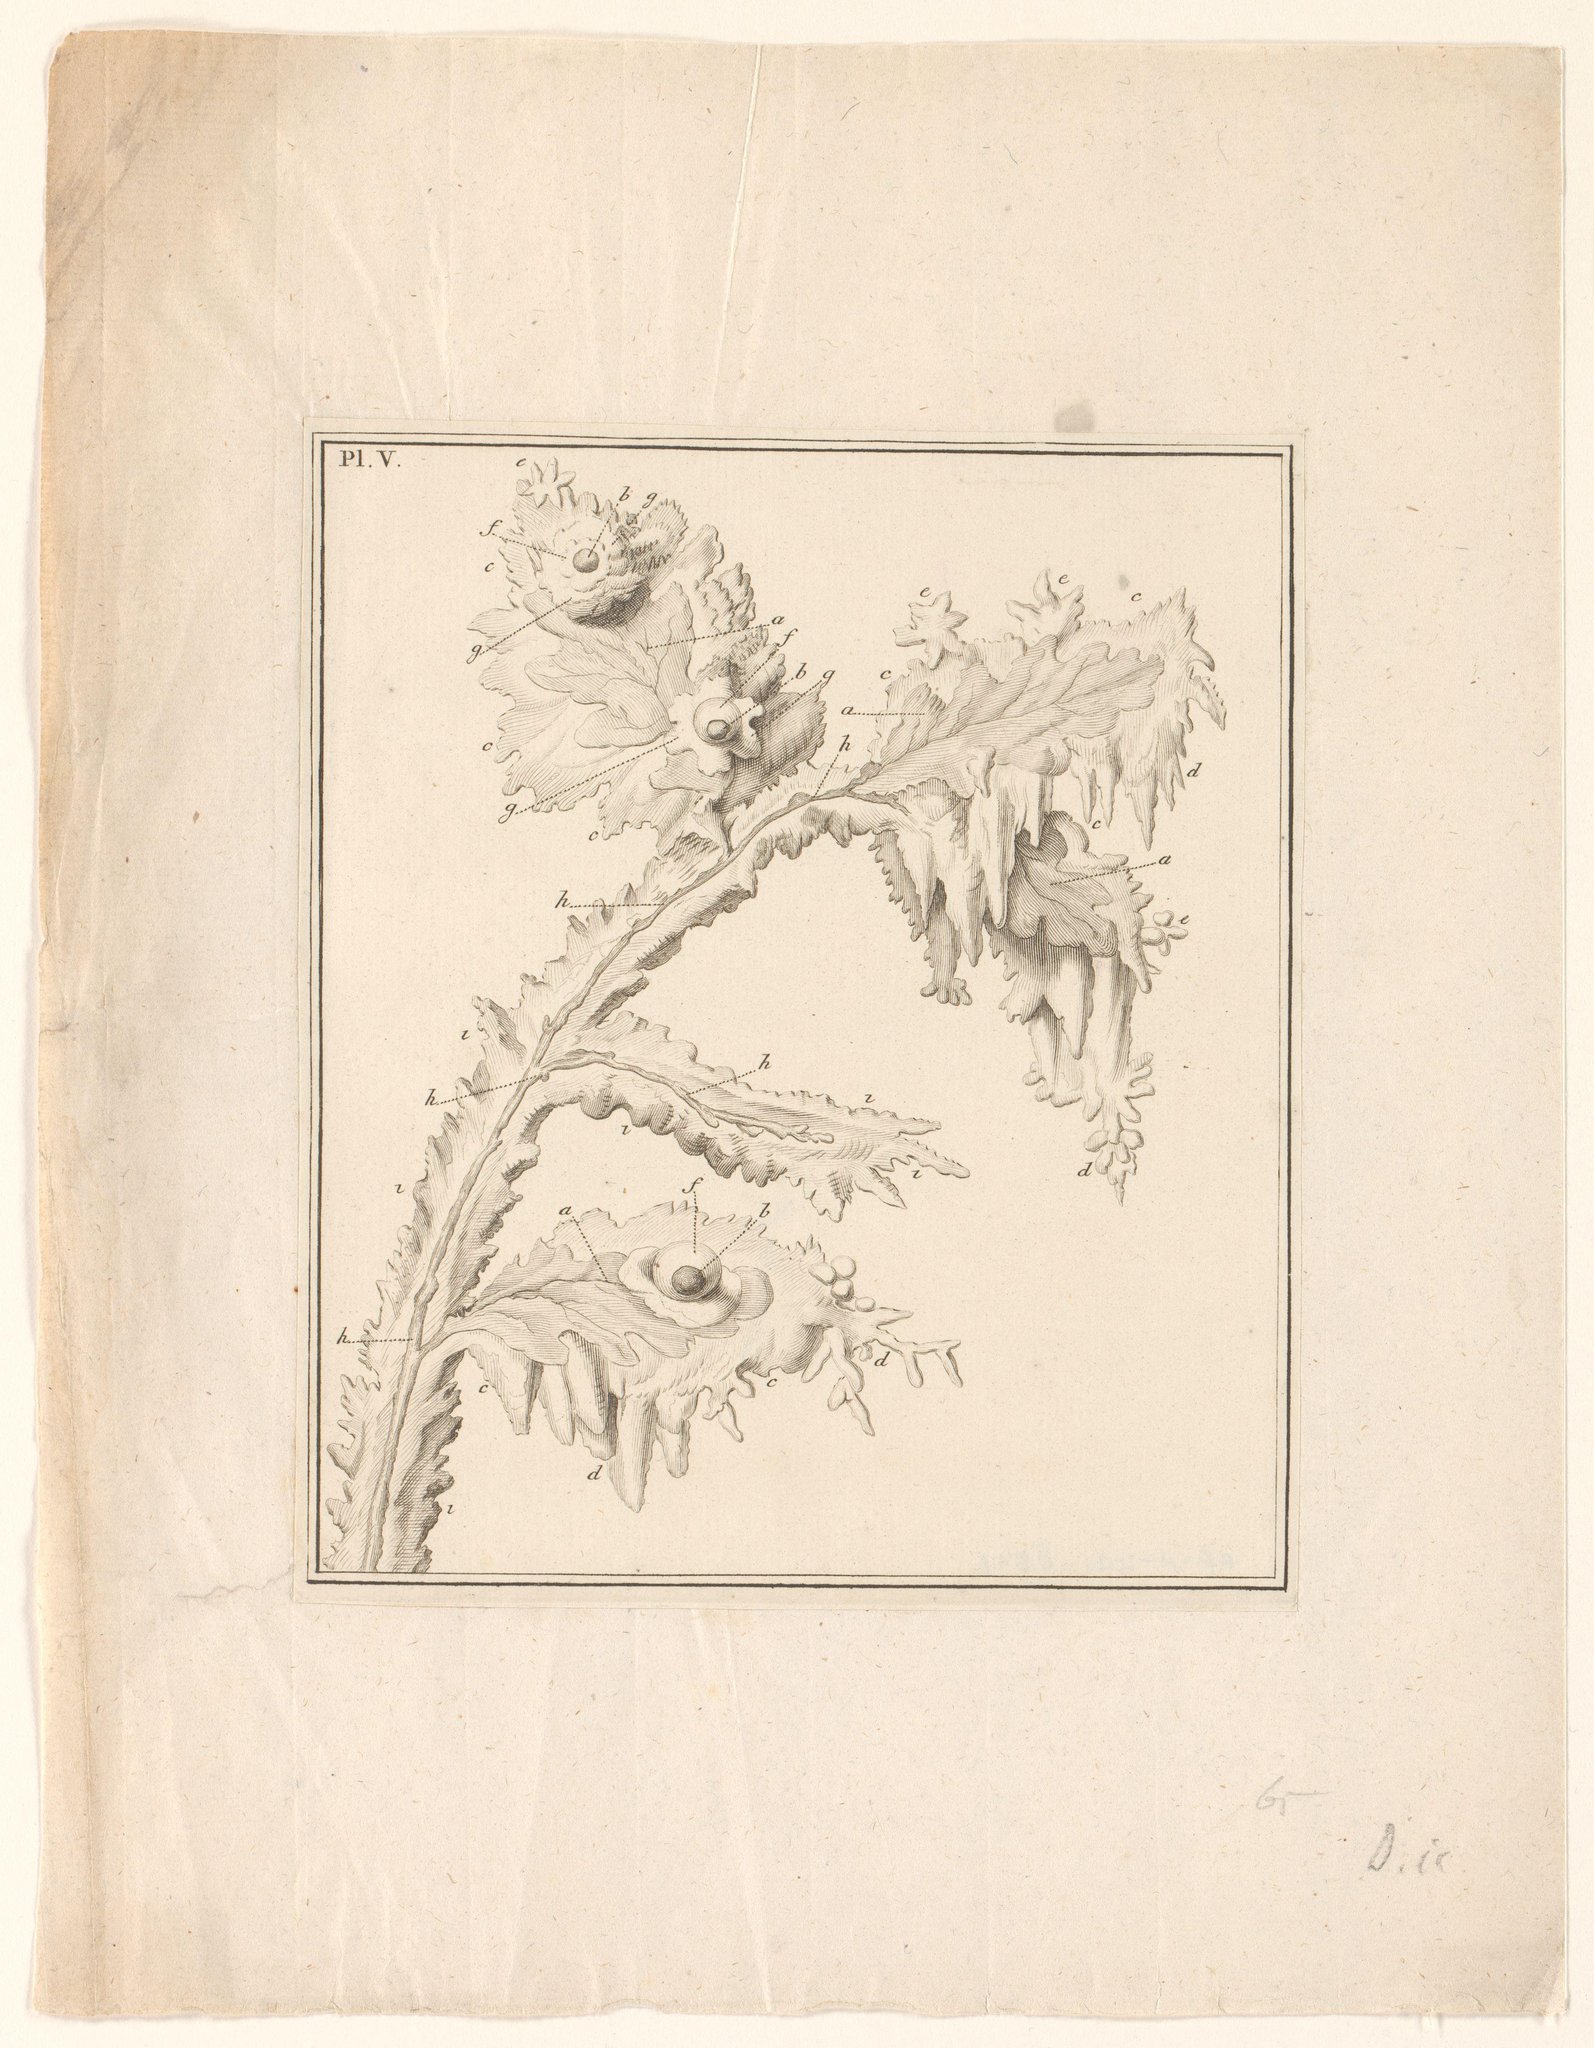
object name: print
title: Bevroren eikenblad met slakken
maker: Anonymous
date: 1700-1799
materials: paper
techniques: etching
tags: trees: oak (+ leaf), frost, freezing weather, molluscs: snail